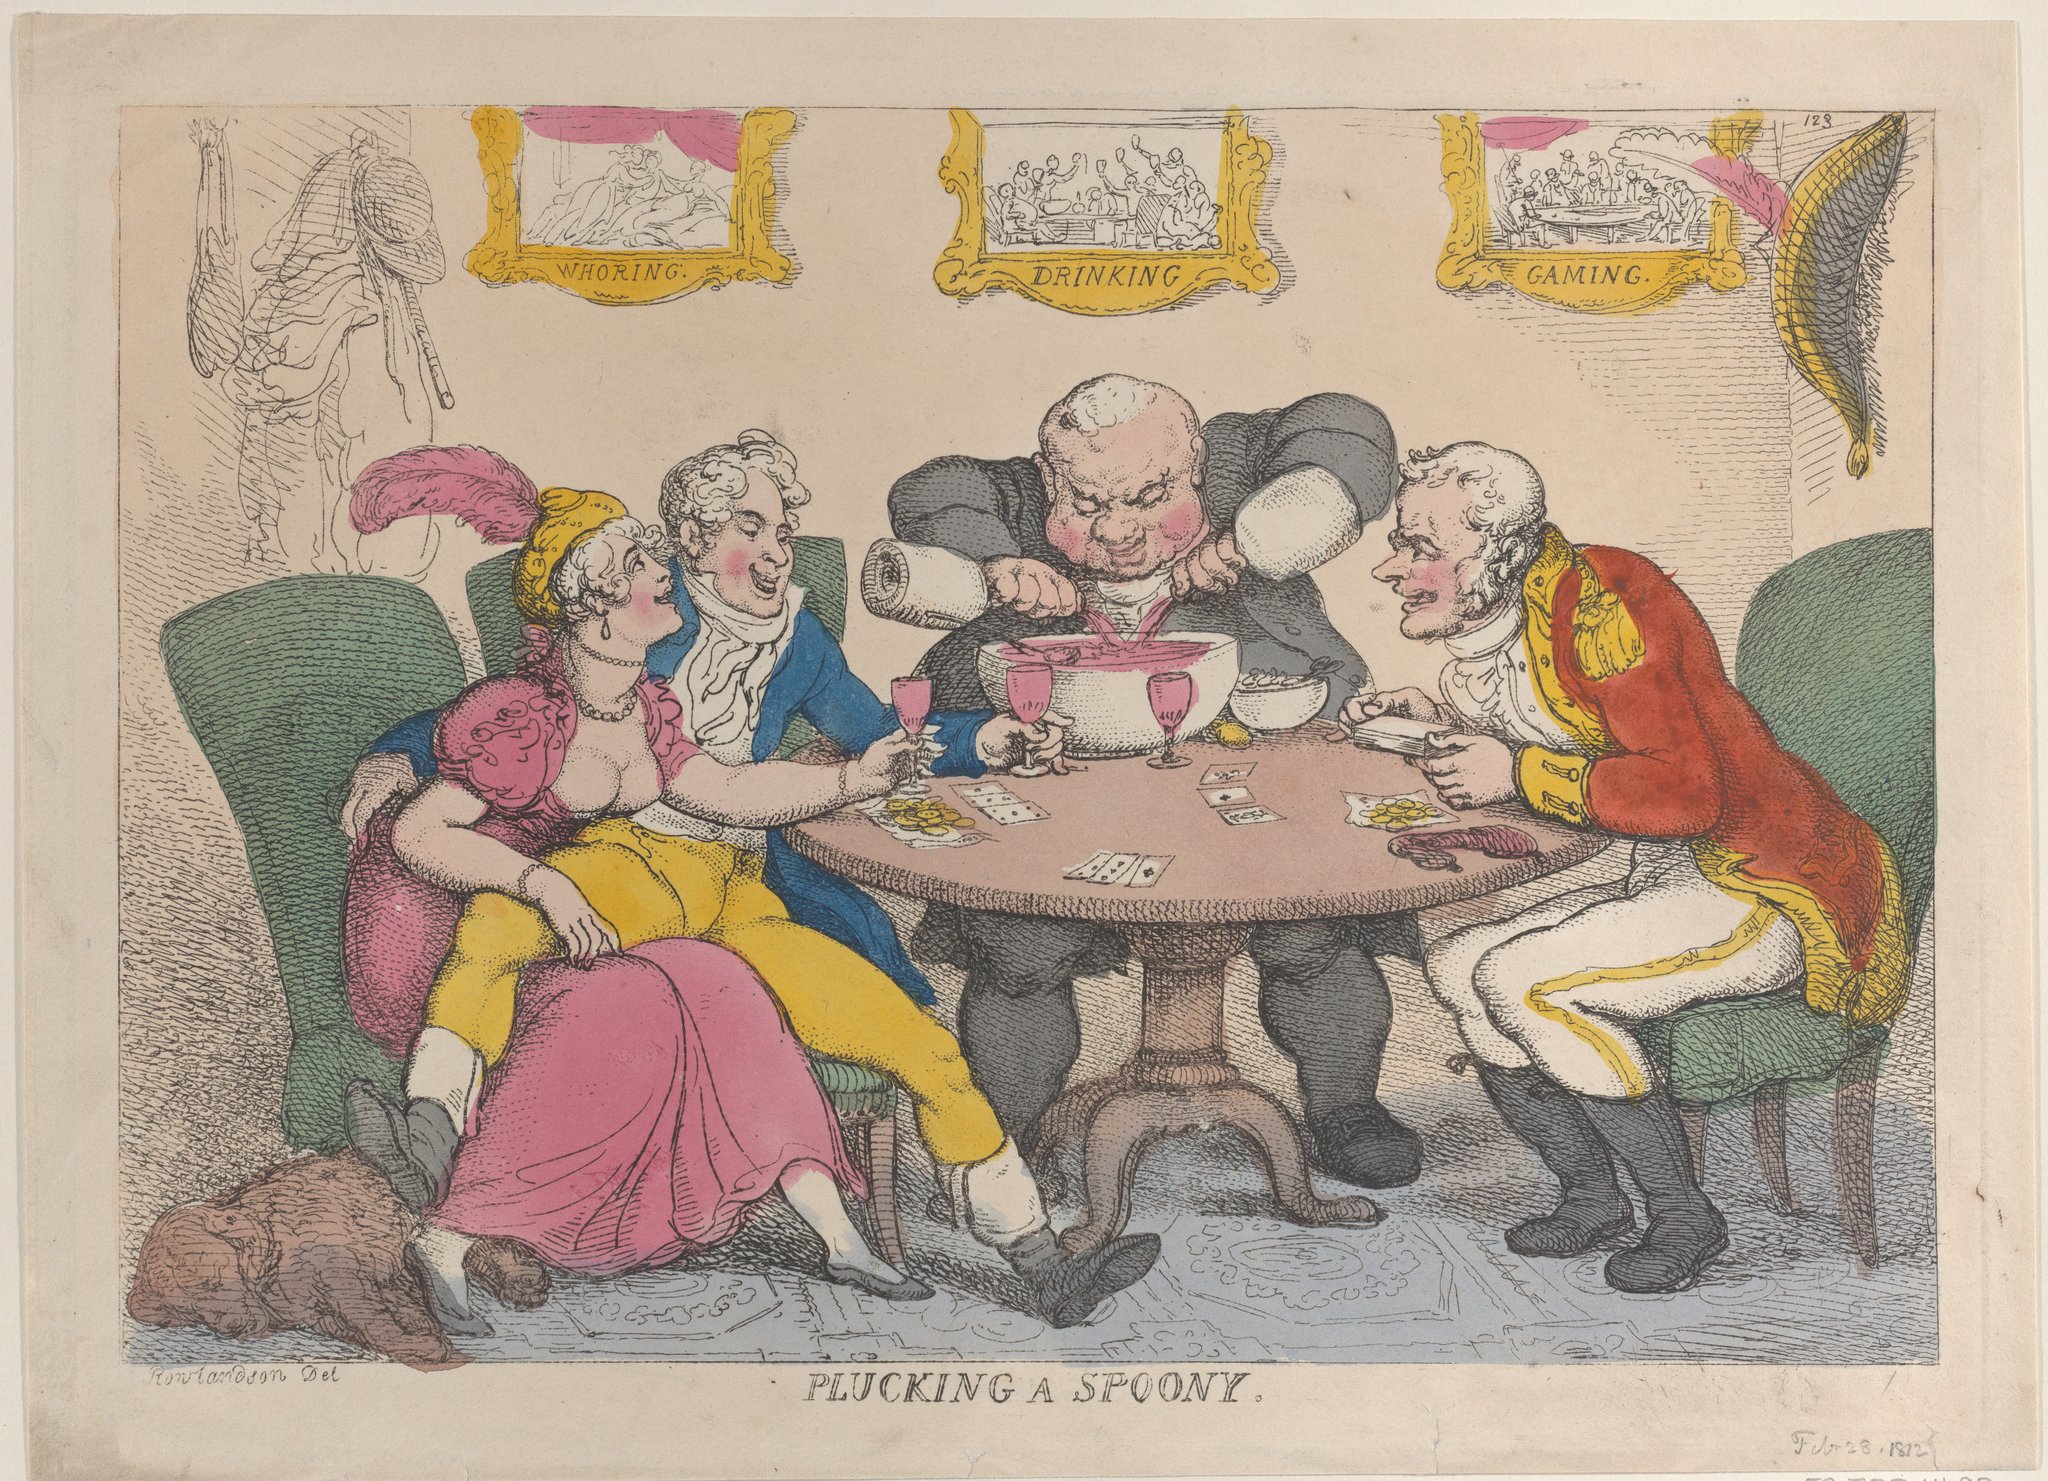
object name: print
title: Plucking a Spoony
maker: thomas rowlandson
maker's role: artist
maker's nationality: british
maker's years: 1757-1827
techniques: etching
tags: satire,men,women,gambling,playing cards,drinking,games